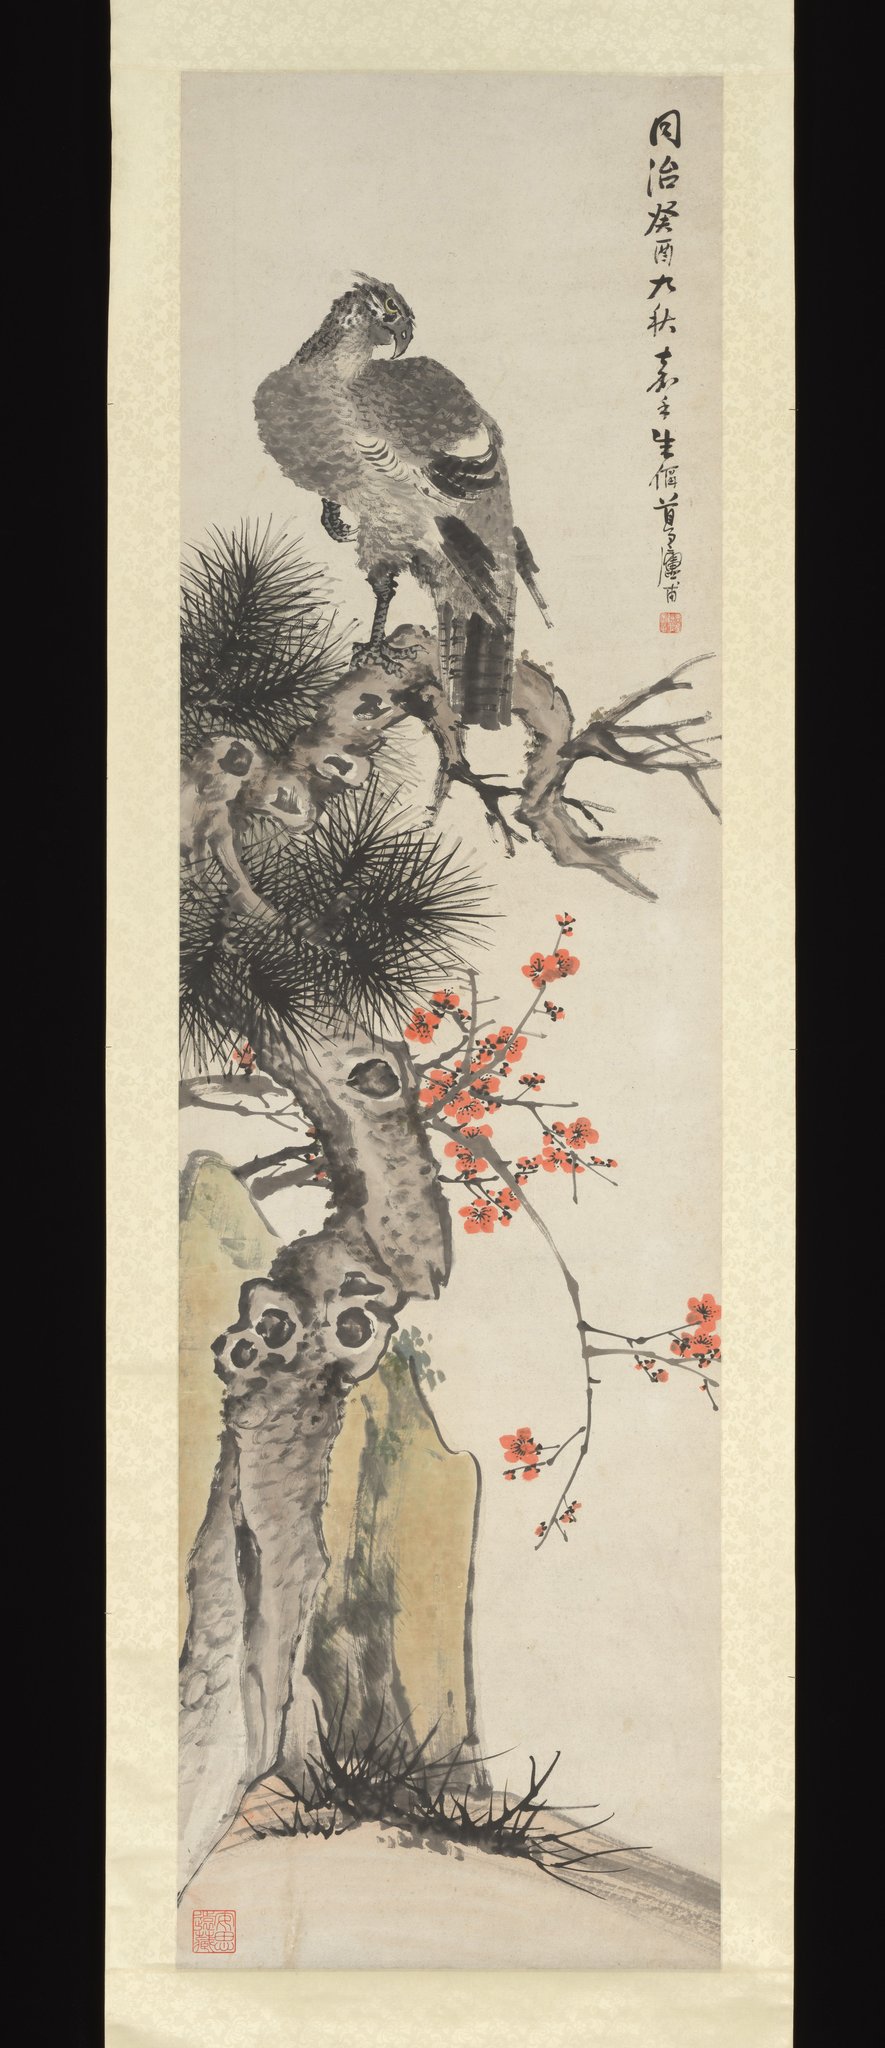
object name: hanging scroll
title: Hawk, pine, plum, and rock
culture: chinese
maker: zhu cheng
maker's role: artist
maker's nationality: chinese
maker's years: 1826-1900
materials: ink, paper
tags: hawks